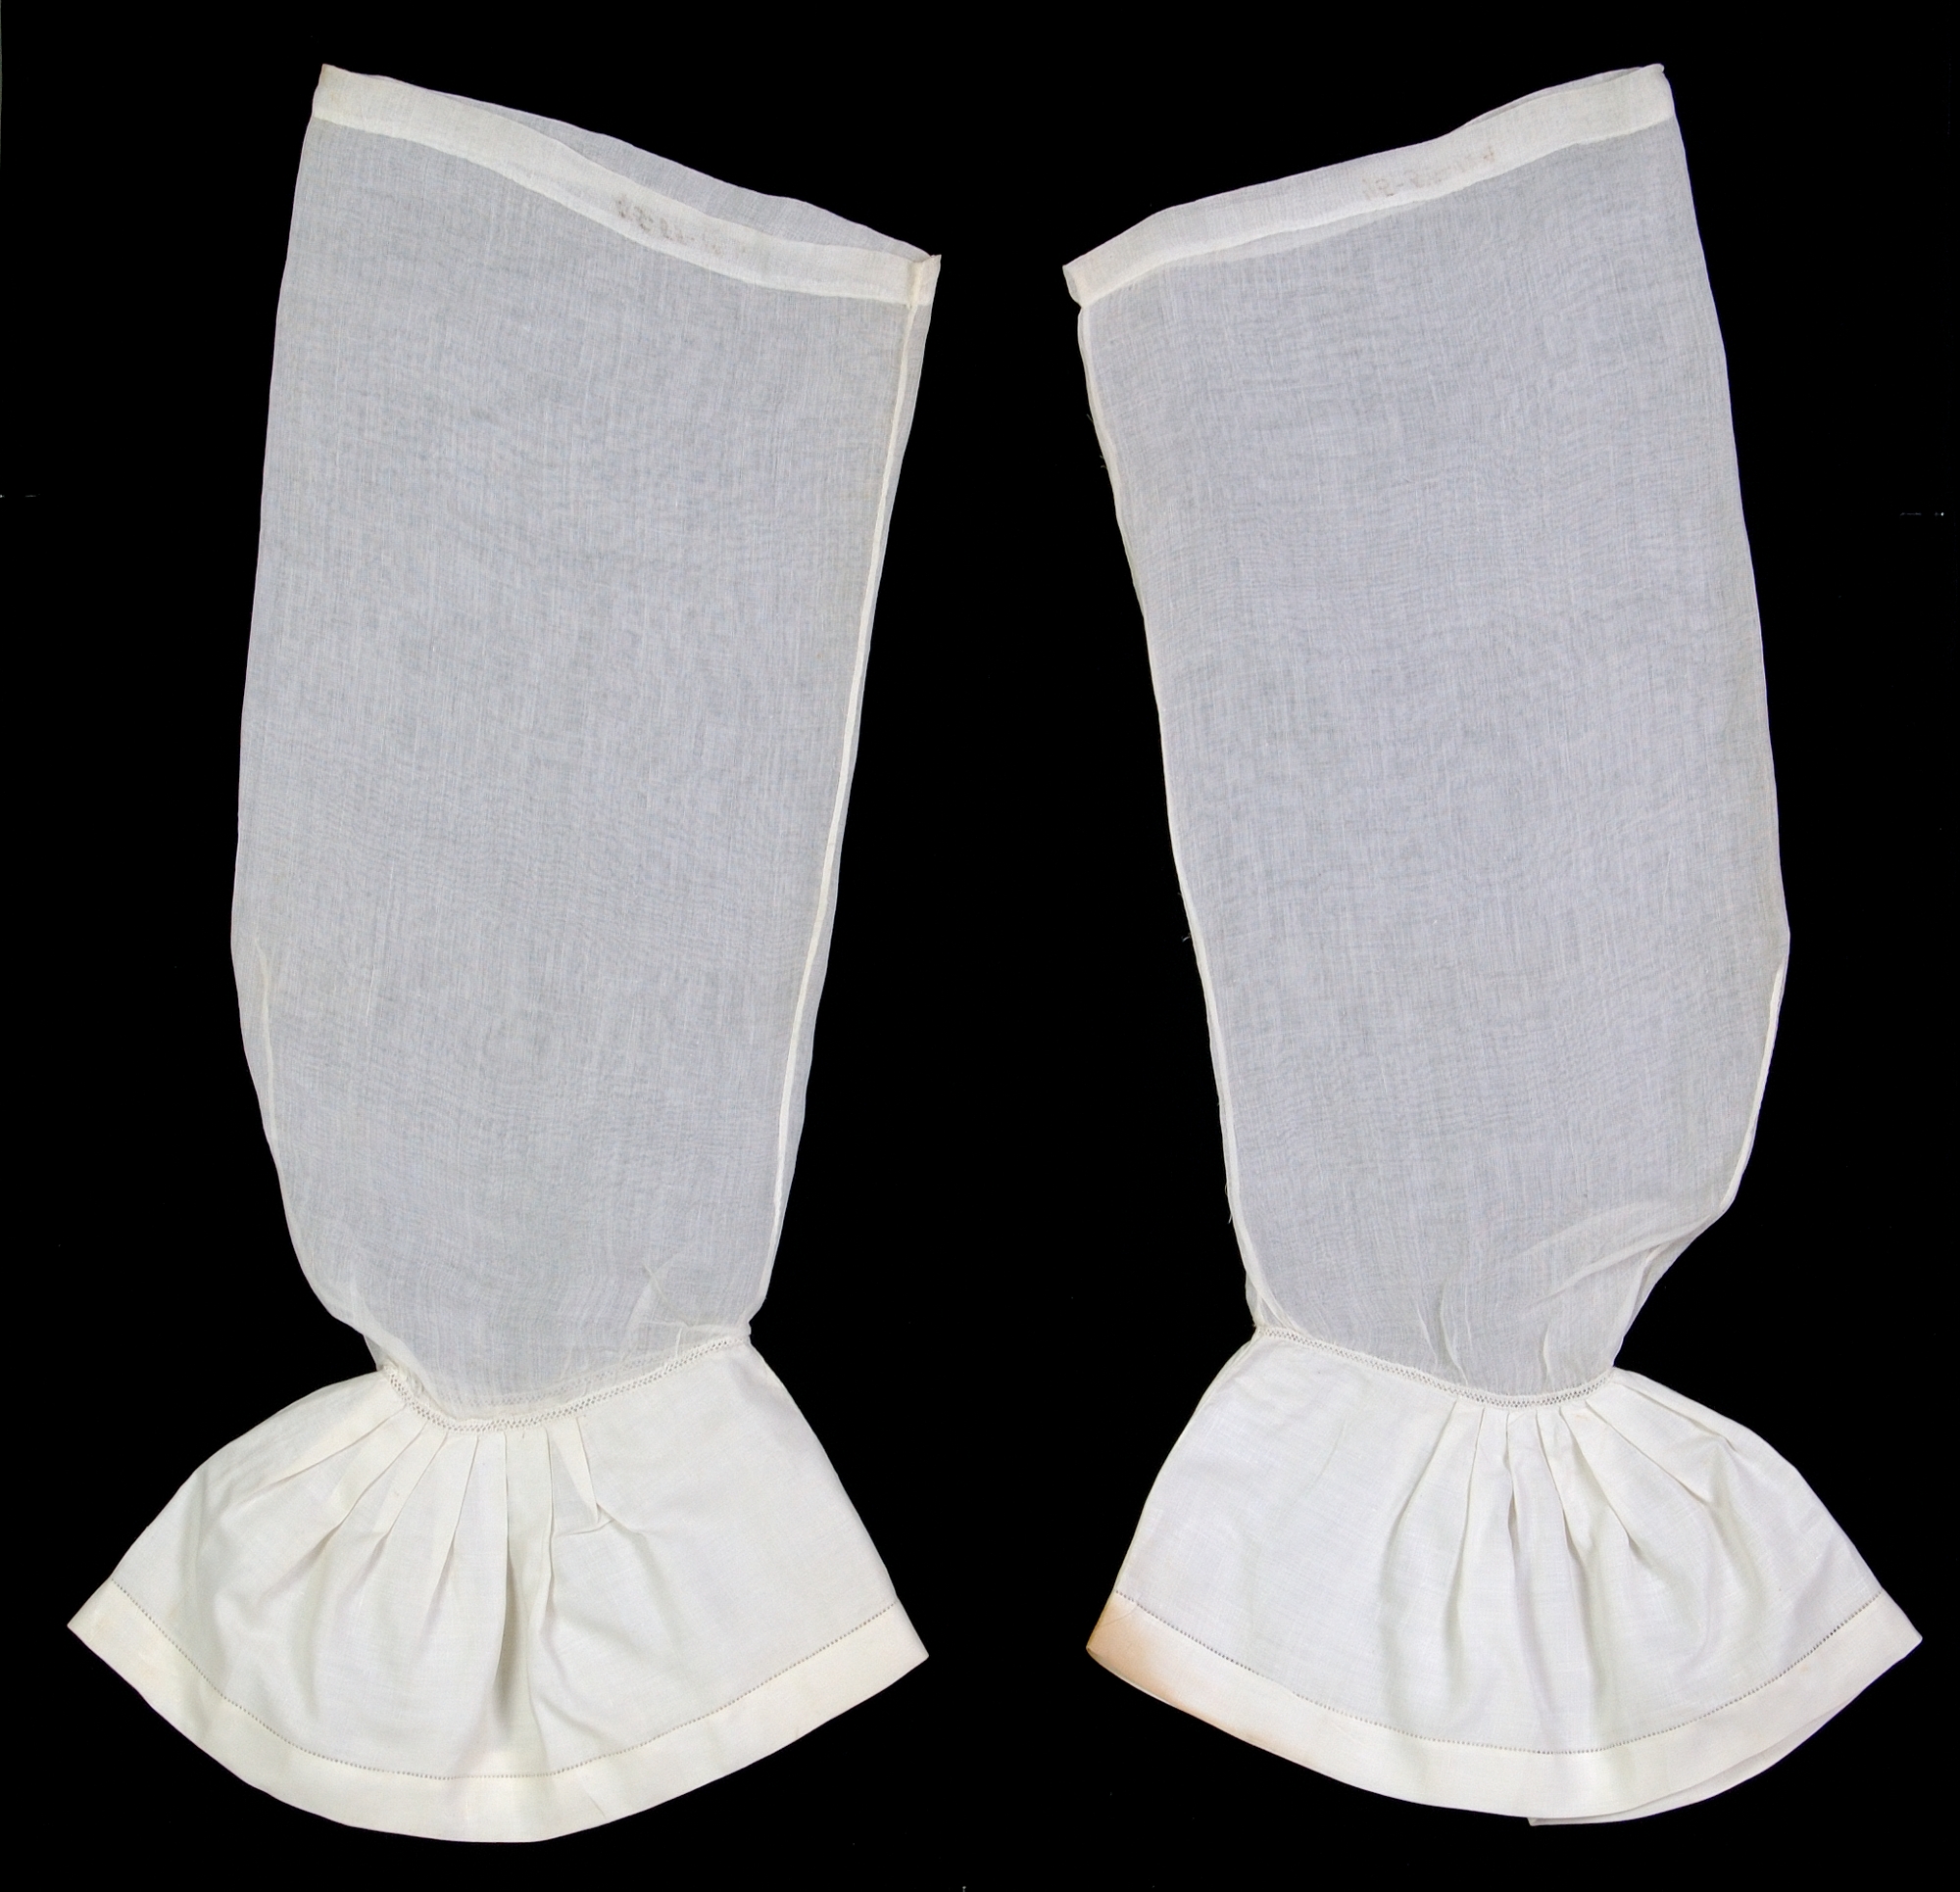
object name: undersleeves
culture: american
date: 1860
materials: cotton, linen